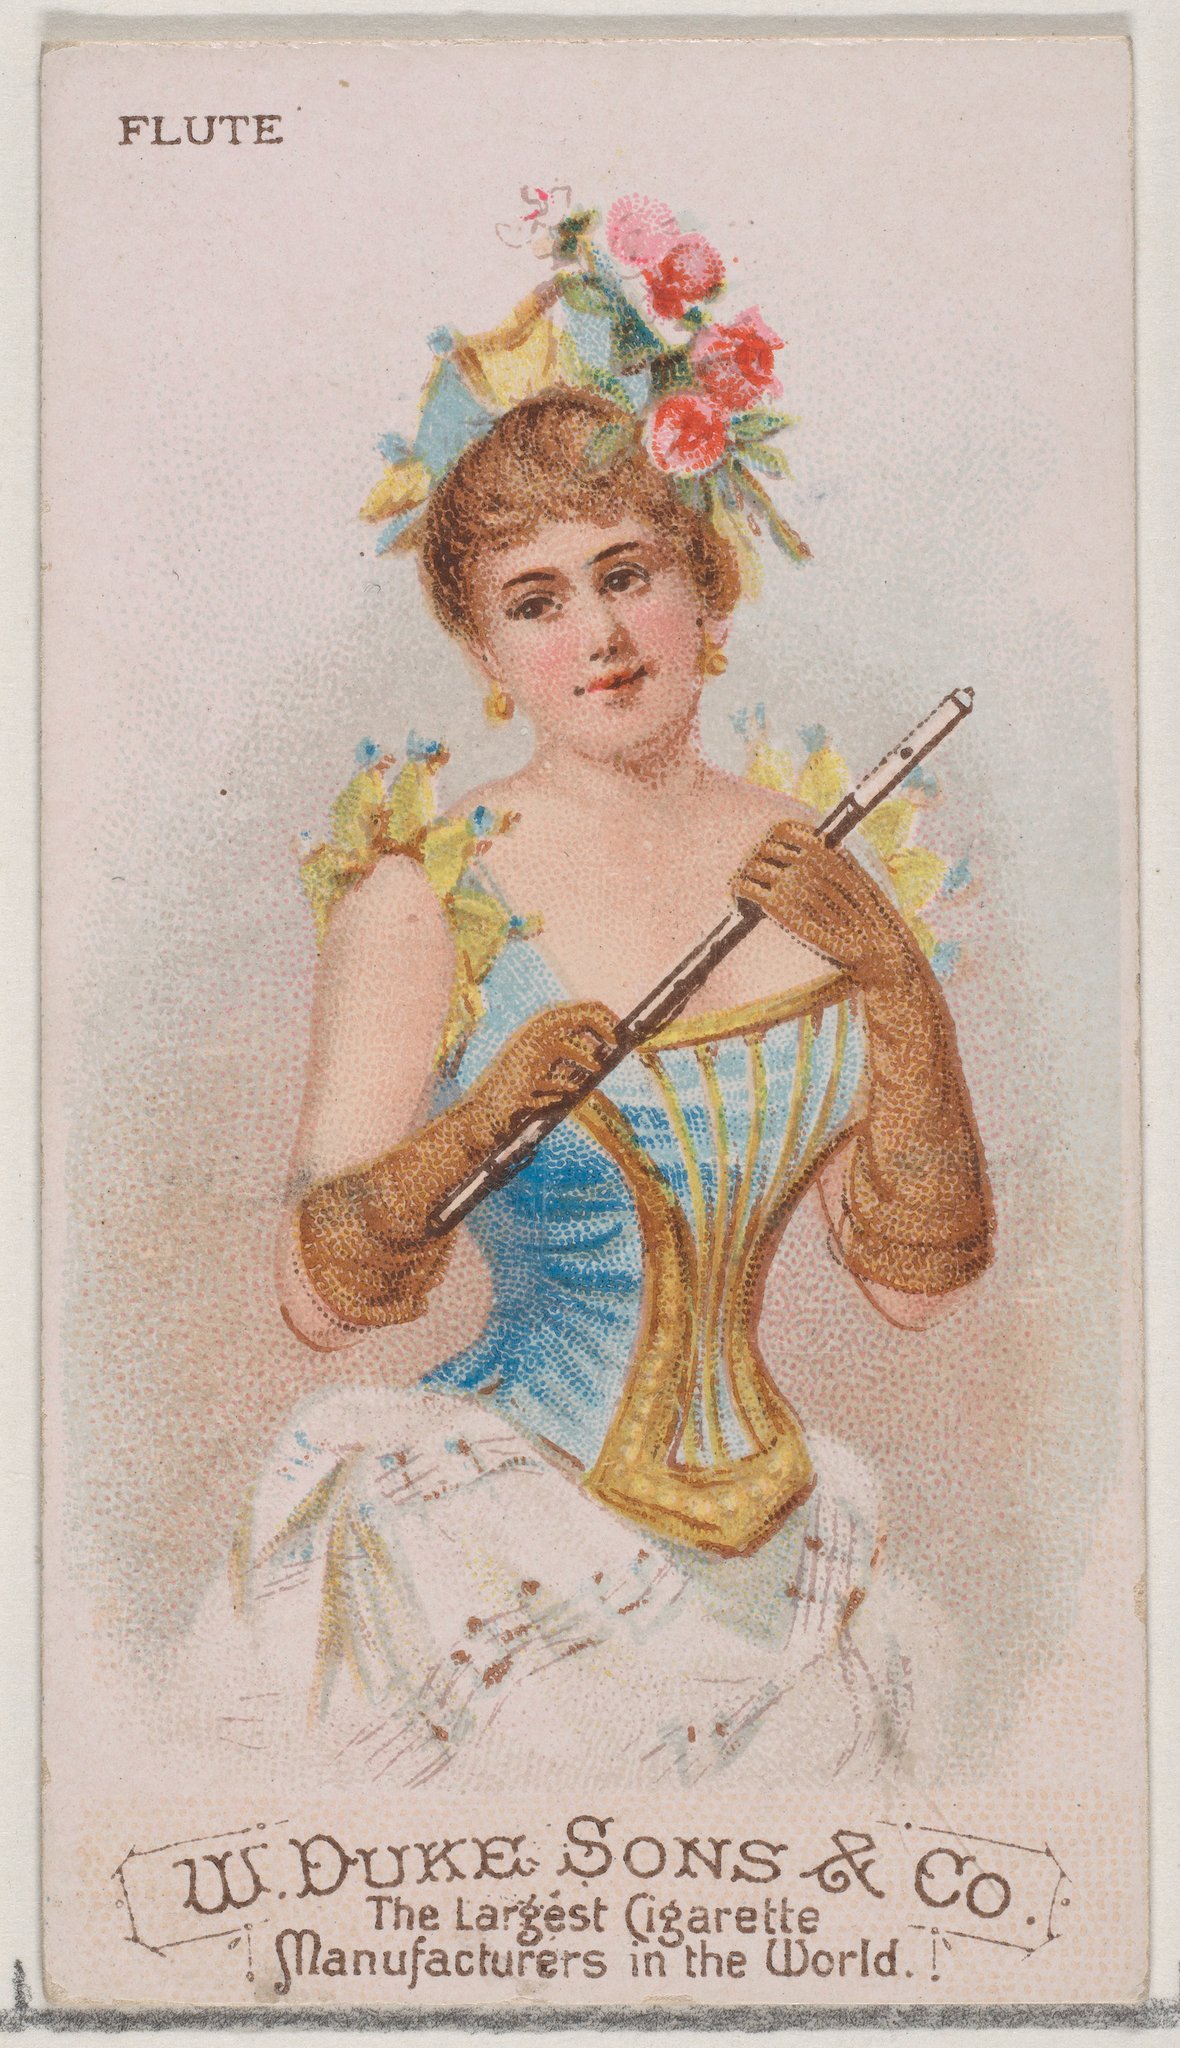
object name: print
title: Flute, from the Musical Instruments series (N82) for Duke brand cigarettes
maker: w. duke, sons & co.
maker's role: publisher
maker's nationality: american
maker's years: 1870-1920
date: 1888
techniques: color lithograph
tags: women,flutes,musicians